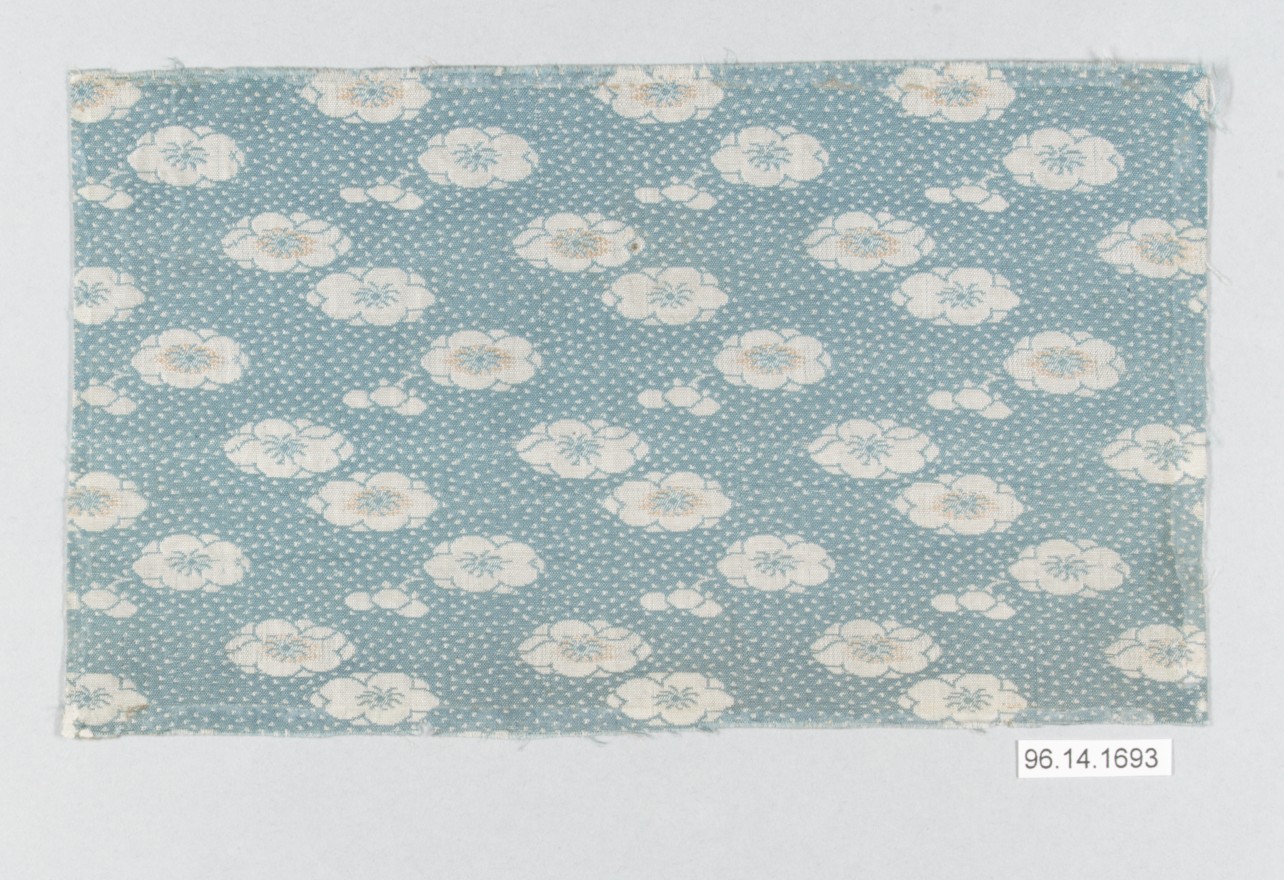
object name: piece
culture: japanese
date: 1701-1800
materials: silk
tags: flowers